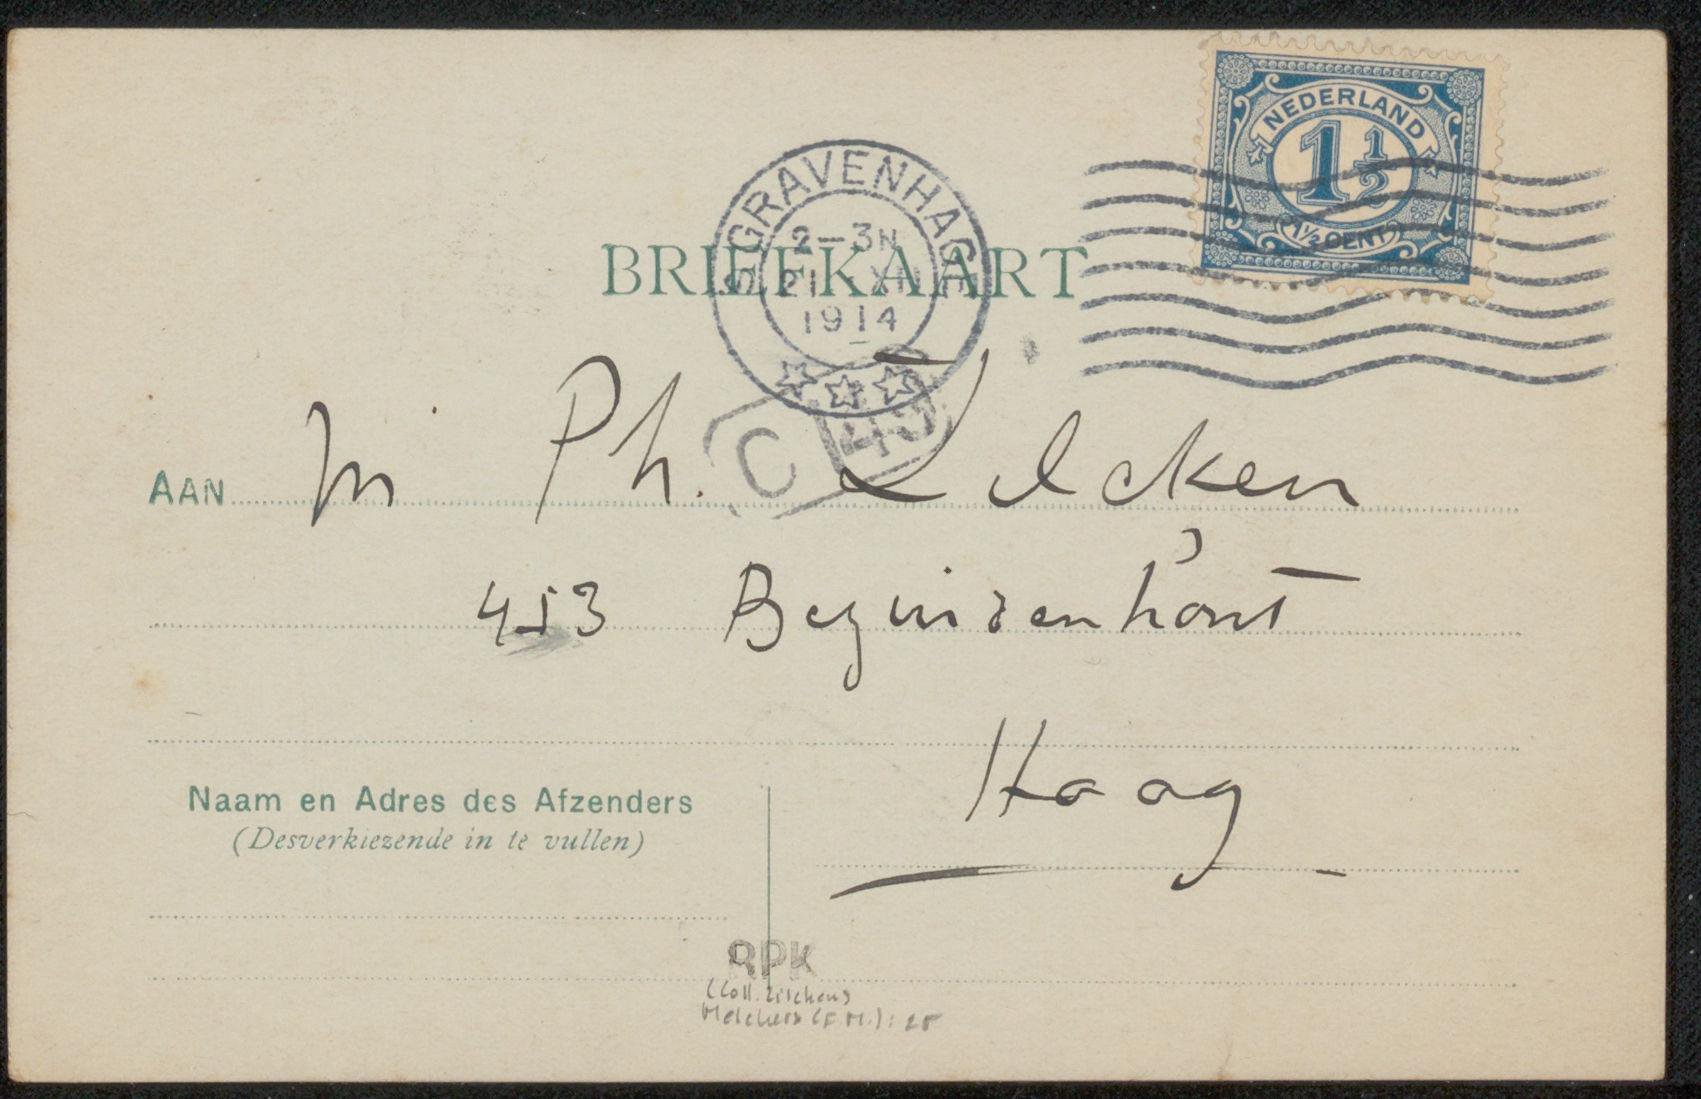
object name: postcard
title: Briefkaart aan Philip Zilcken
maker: franz melchers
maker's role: draughtsman, painter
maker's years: 1868-1944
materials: cardboard, ink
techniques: pen, writing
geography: the hague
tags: maria biermé, the hague, philip zilcken, anonymous historical person portrayed, london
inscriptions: collector's mark: ‘RPK’